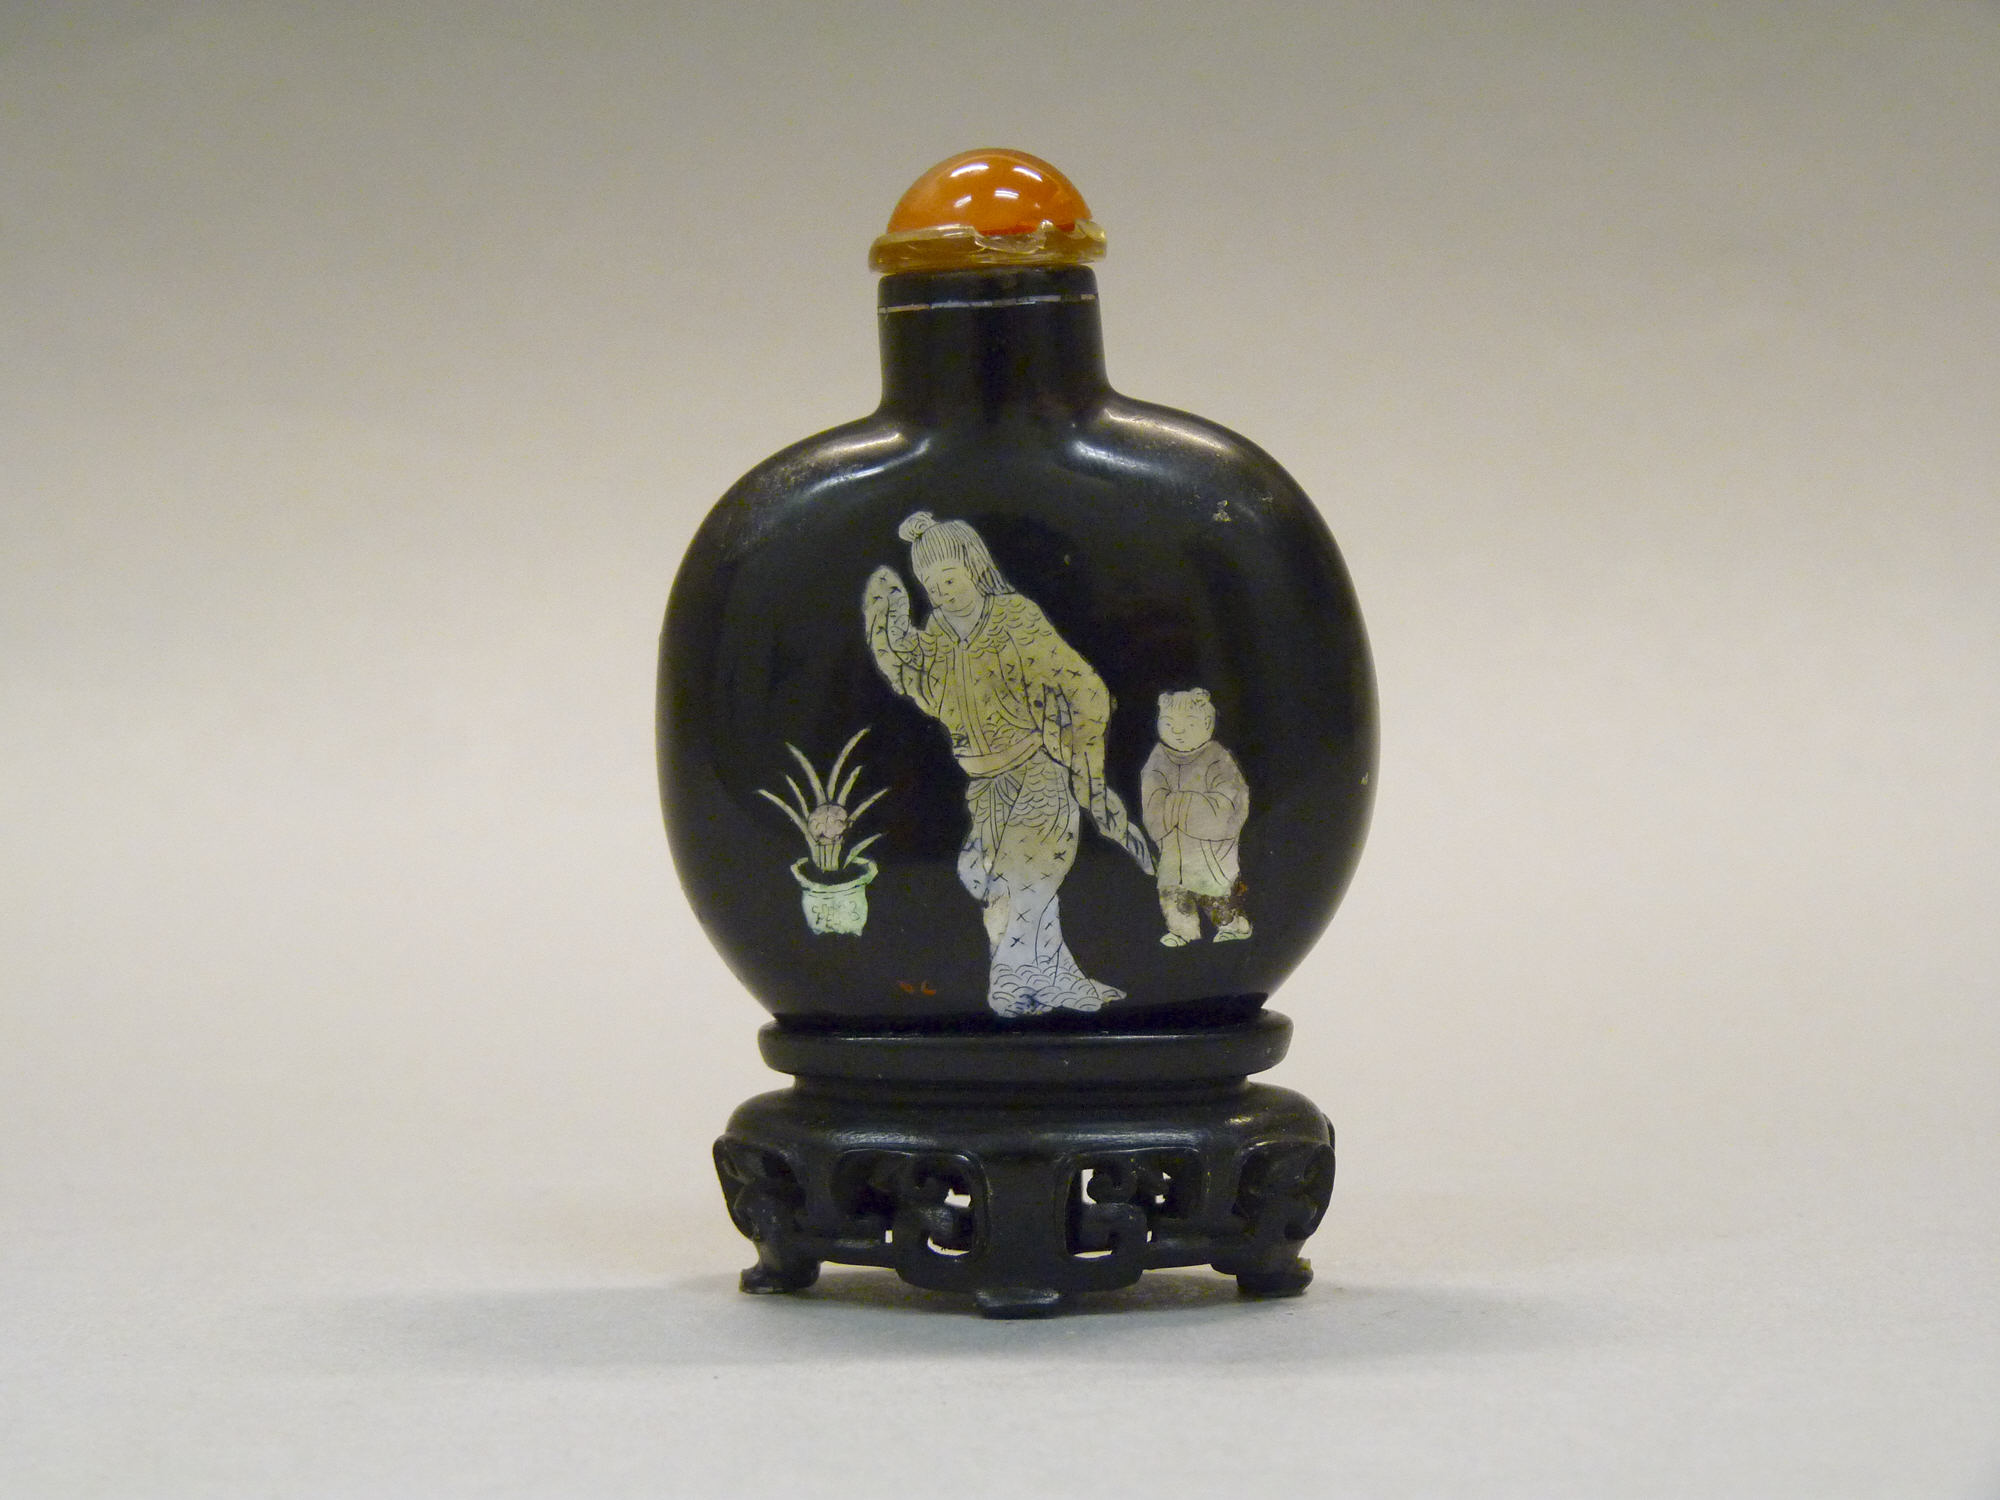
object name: snuff bottle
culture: chinese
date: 1736-1795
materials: amber, lacquer, mother of pearl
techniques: inlay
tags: human figures,children